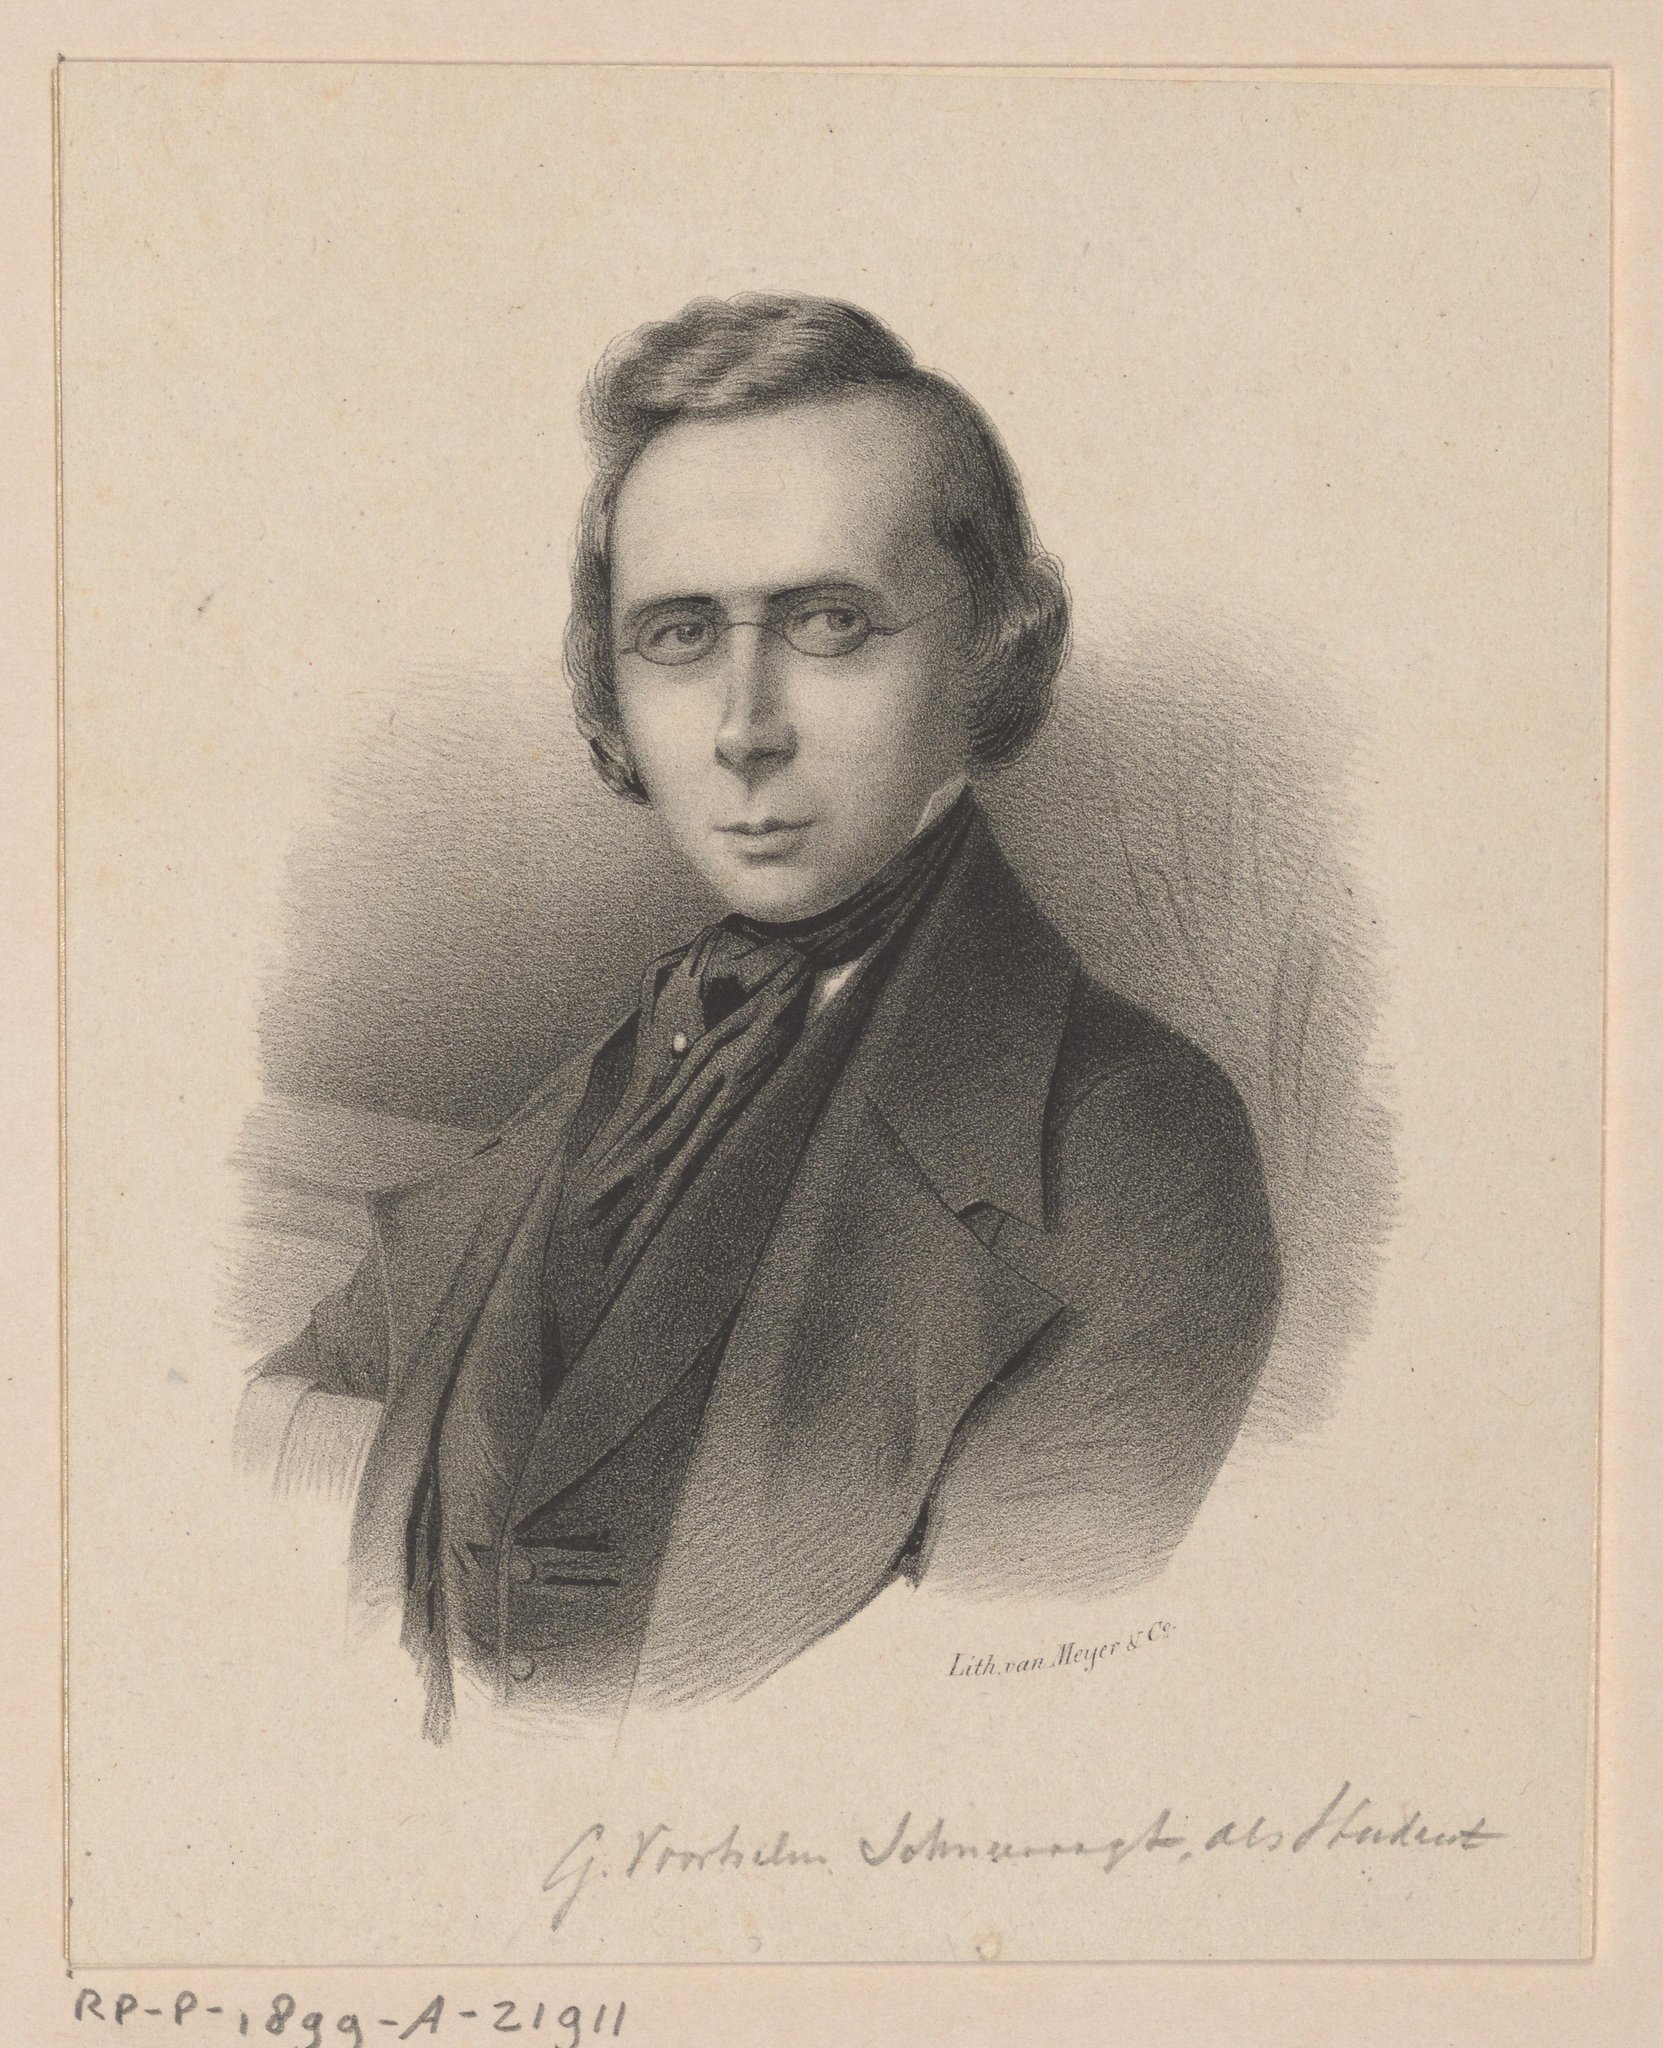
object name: print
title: Portret van Gustaaf Eduard Voorhelm Schneevoogt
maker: Anonymous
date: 1843-1856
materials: cardboard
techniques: lithograph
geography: amsterdam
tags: historical persons, physician, doctor